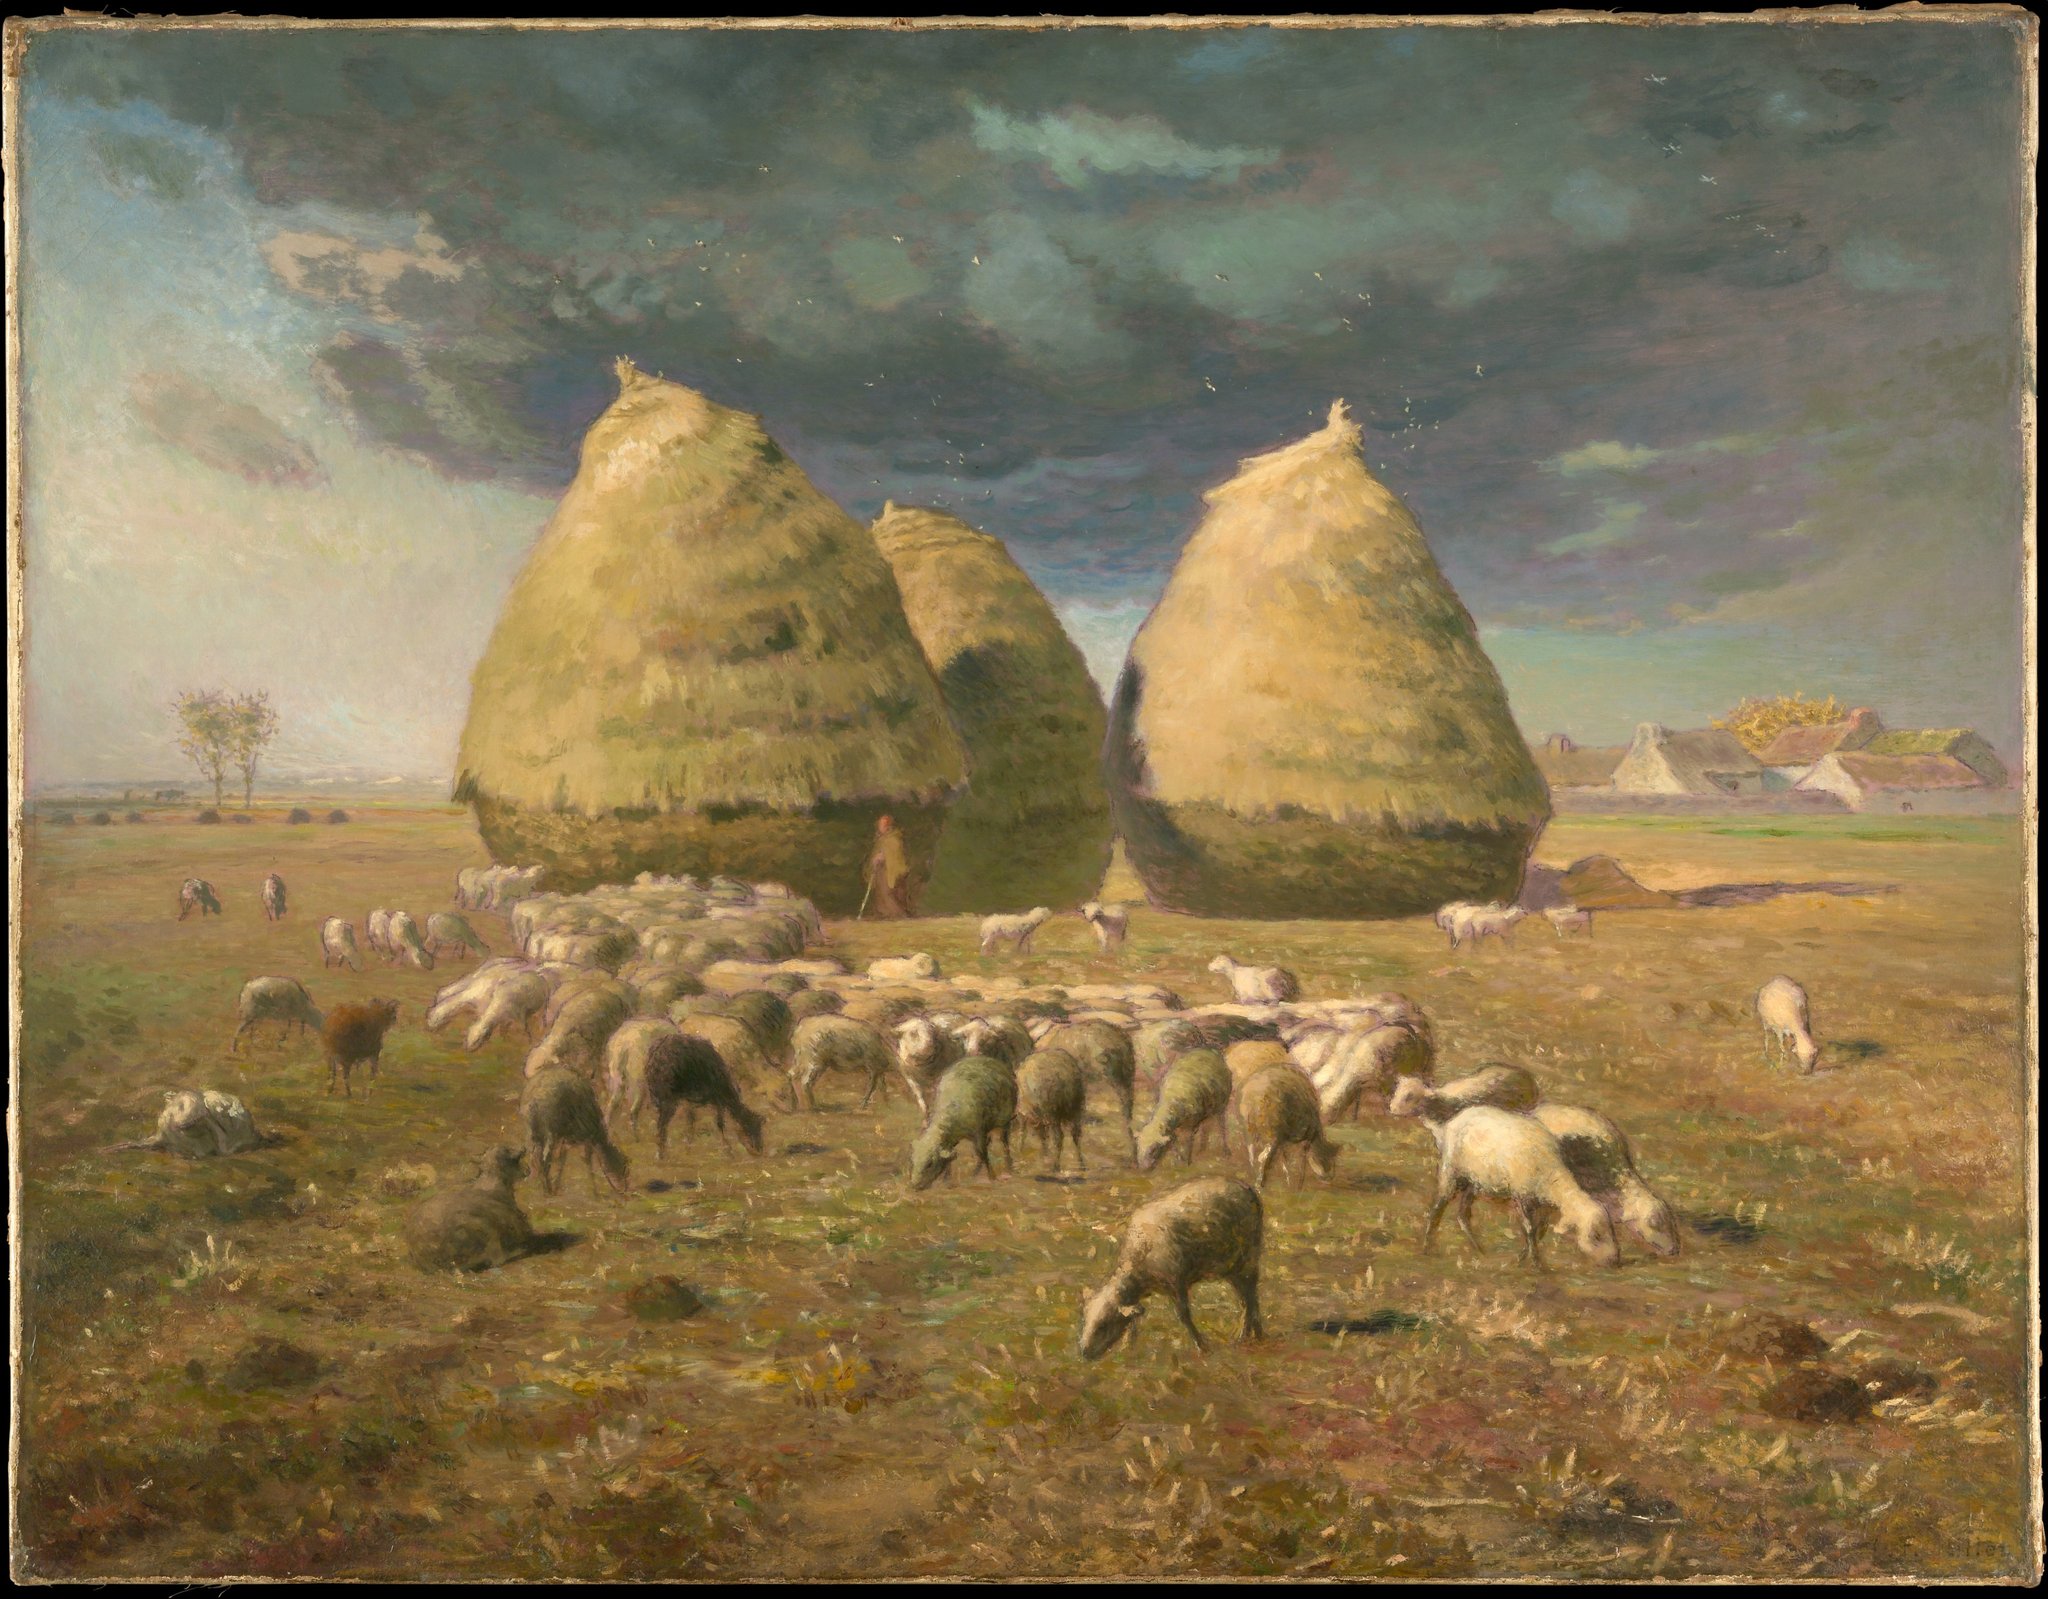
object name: painting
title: Haystacks: Autumn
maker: jean-françois millet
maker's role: artist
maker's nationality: french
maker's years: 1814-1875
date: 1874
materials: canvas, oil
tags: sheep,landscapes,autumn,haystacks